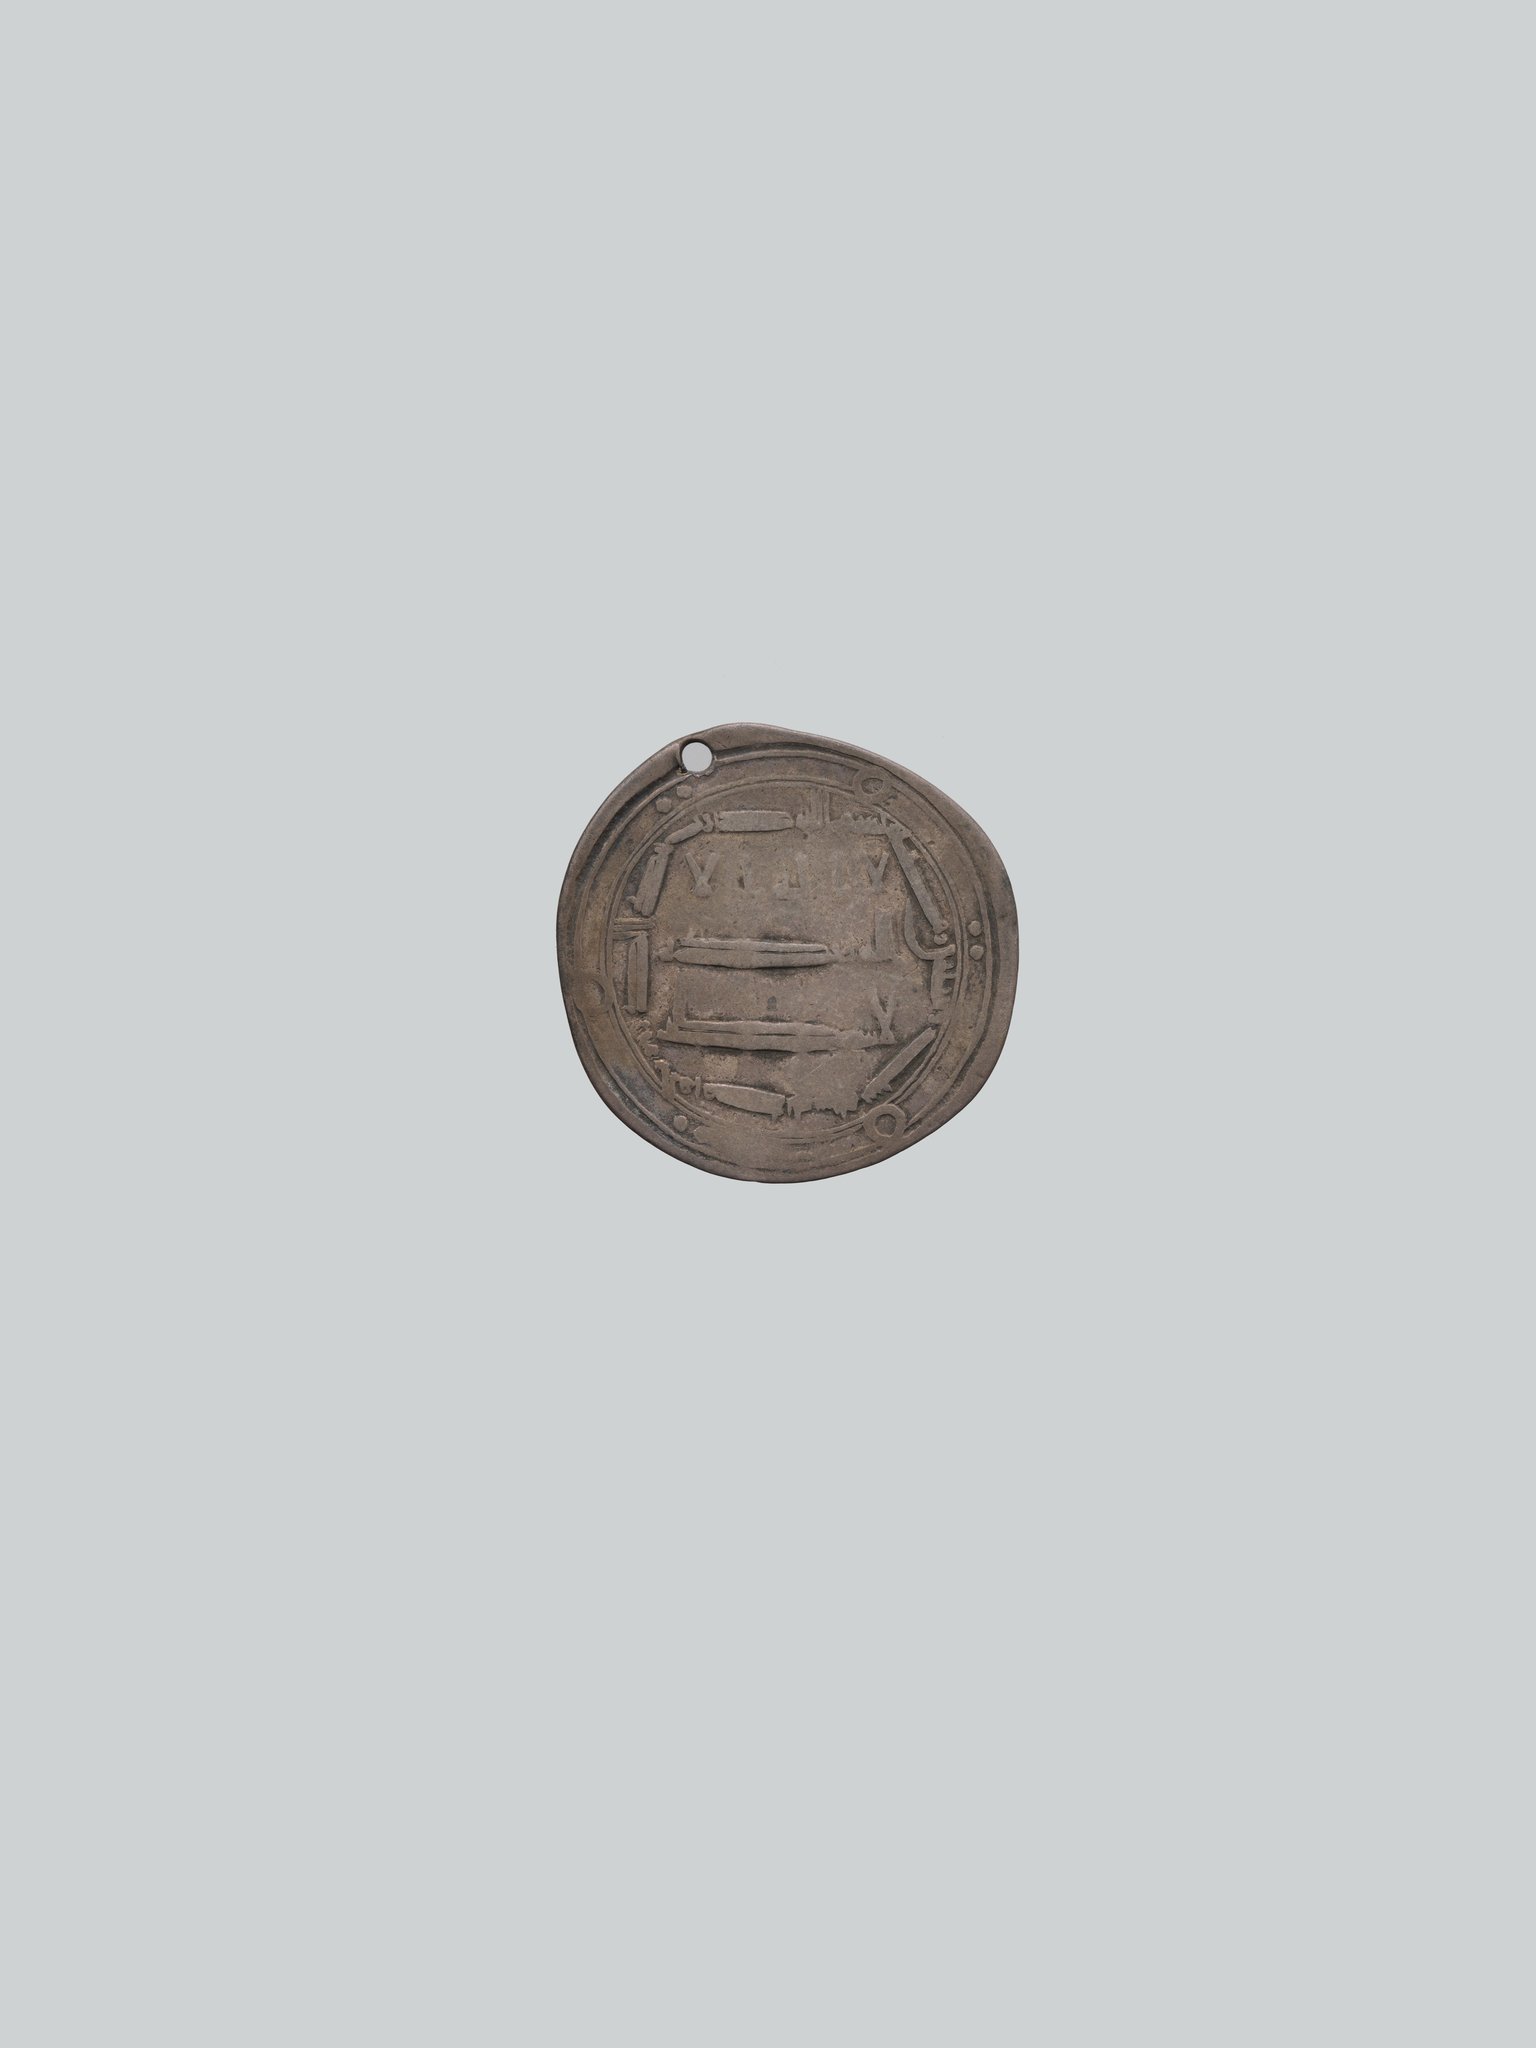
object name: coin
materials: silver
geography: iran